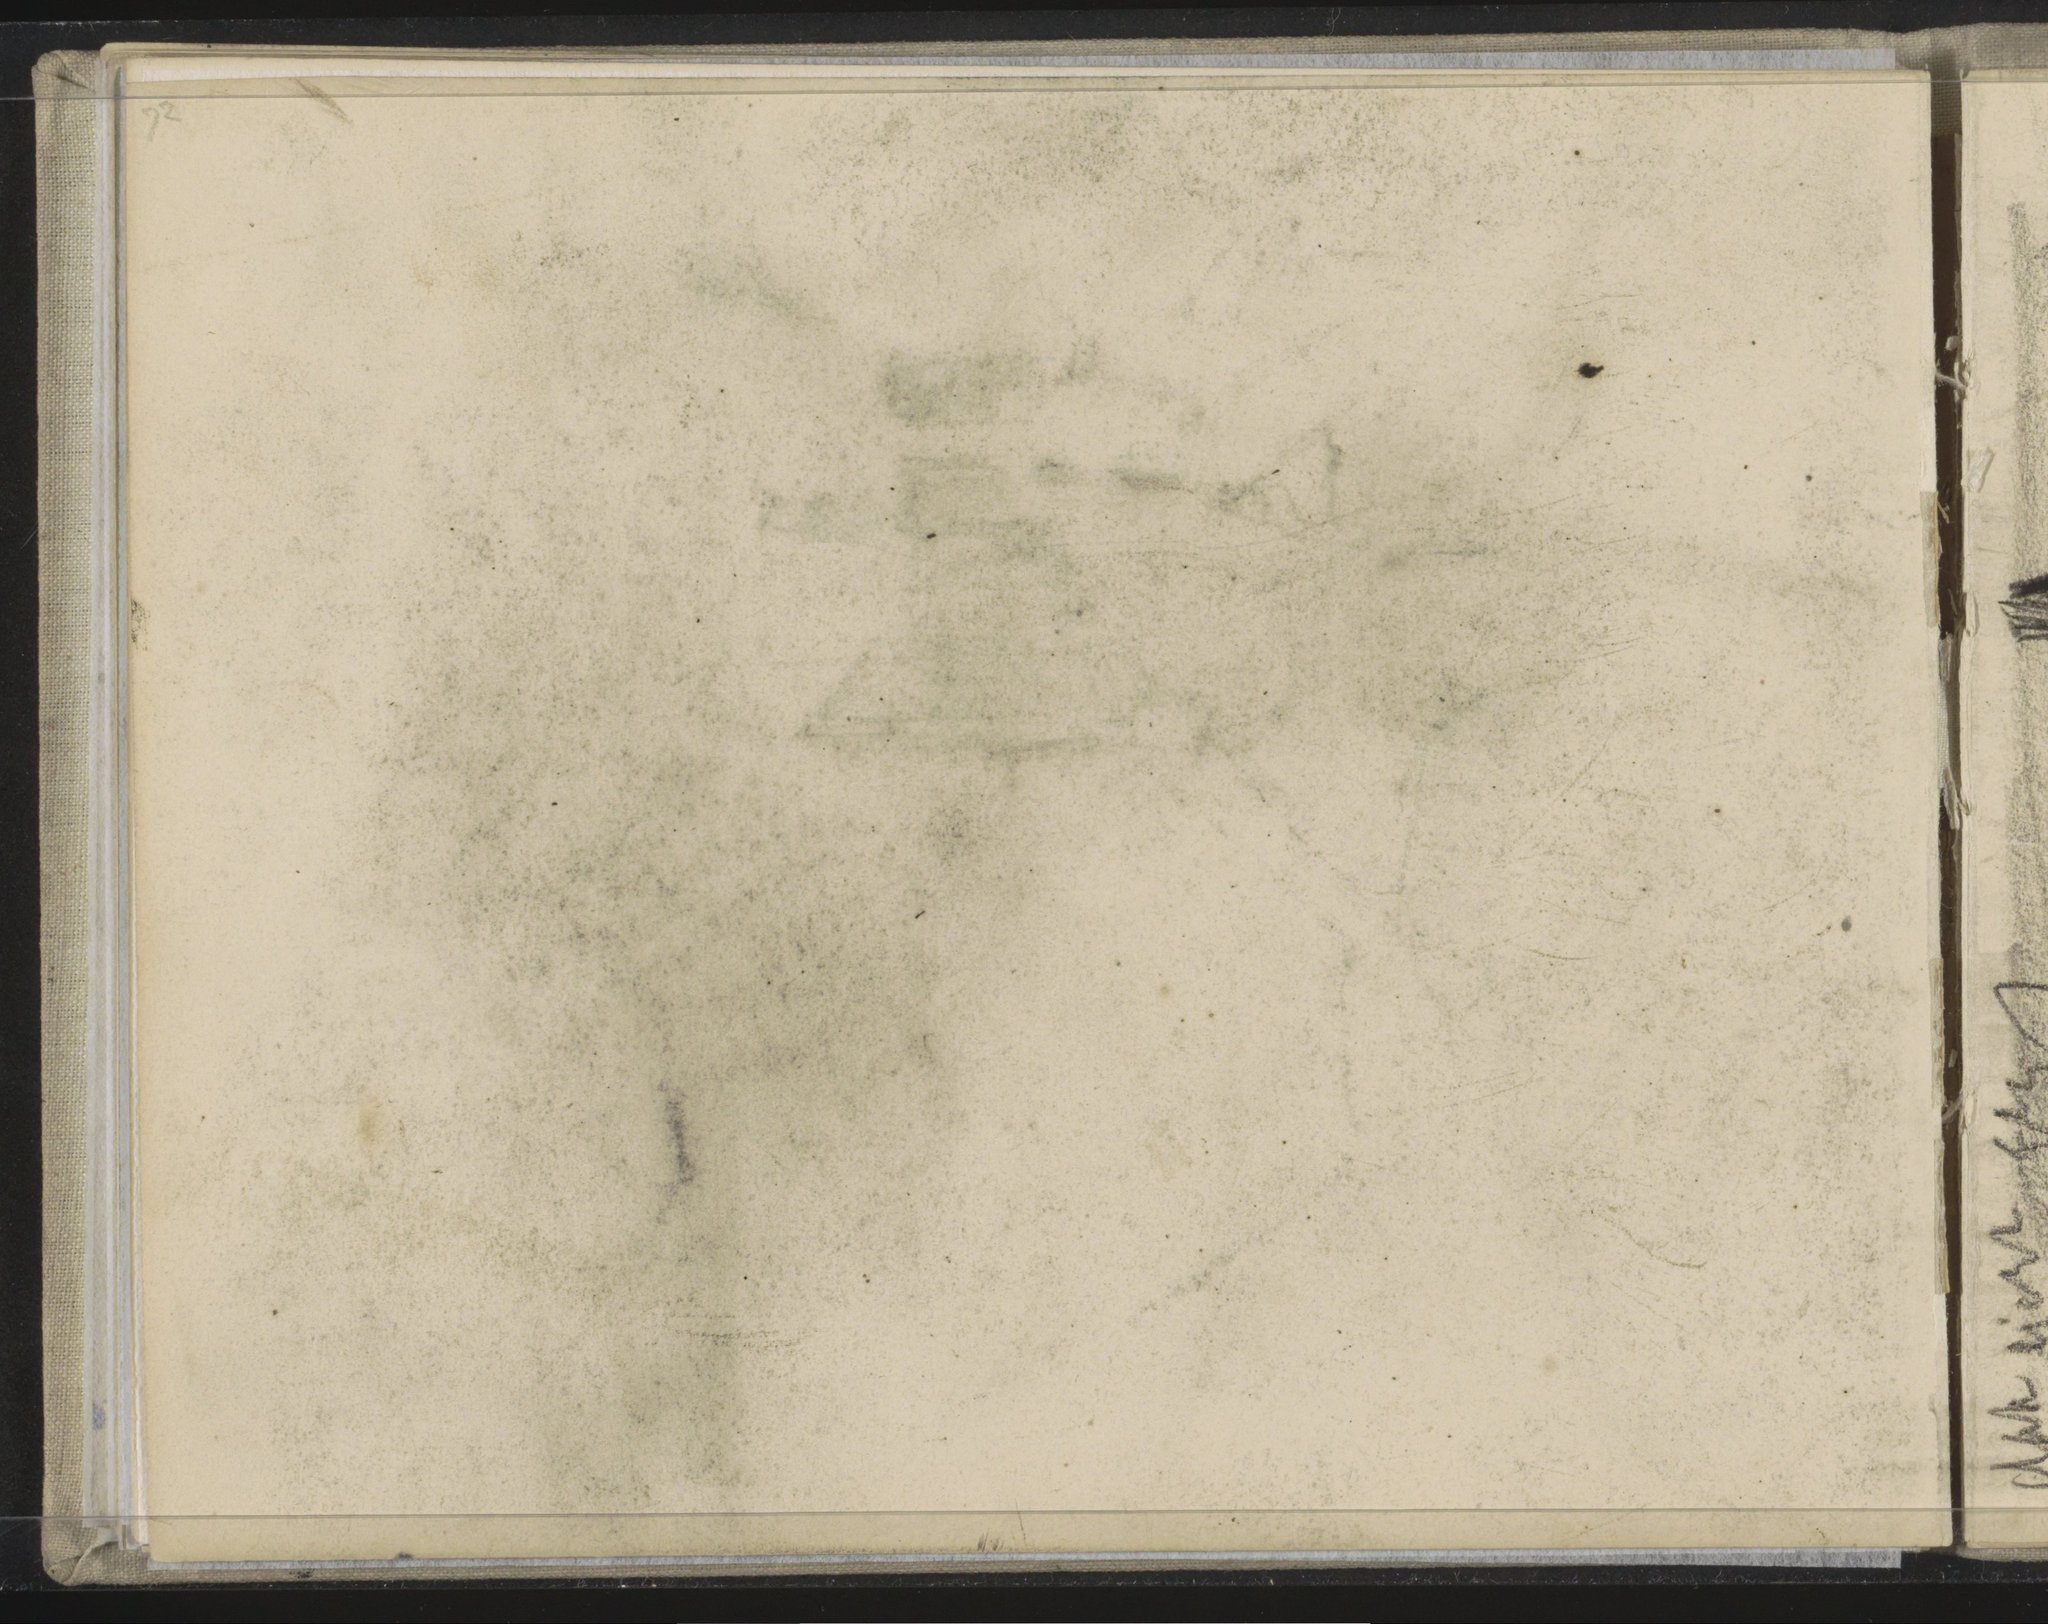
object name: sketchbook leaf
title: Abklatsch van de krijttekening op pagina 73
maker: willem witsen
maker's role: draughtsman, painter, print maker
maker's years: 1860-1923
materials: paper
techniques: printmaking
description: Pagina 72 uit een schetsboek met 43 bladen.